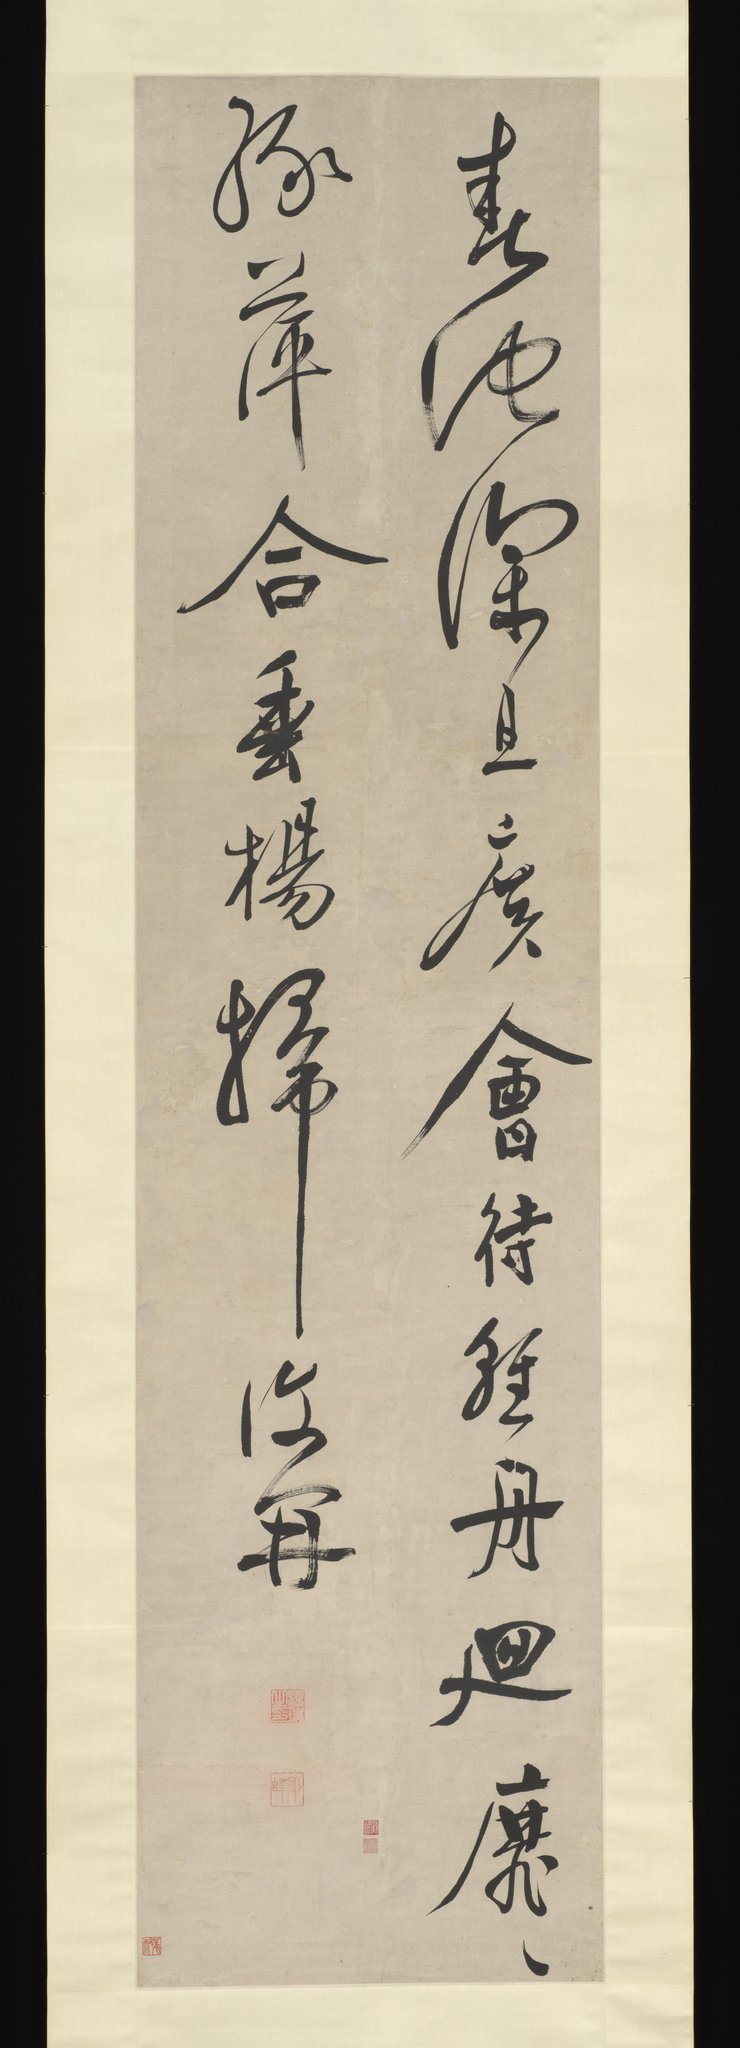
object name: hanging scroll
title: Poem on a Spring Pool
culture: chinese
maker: hai rui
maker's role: artist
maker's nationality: chinese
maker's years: 1514-1587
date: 1514-1587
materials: ink, paper